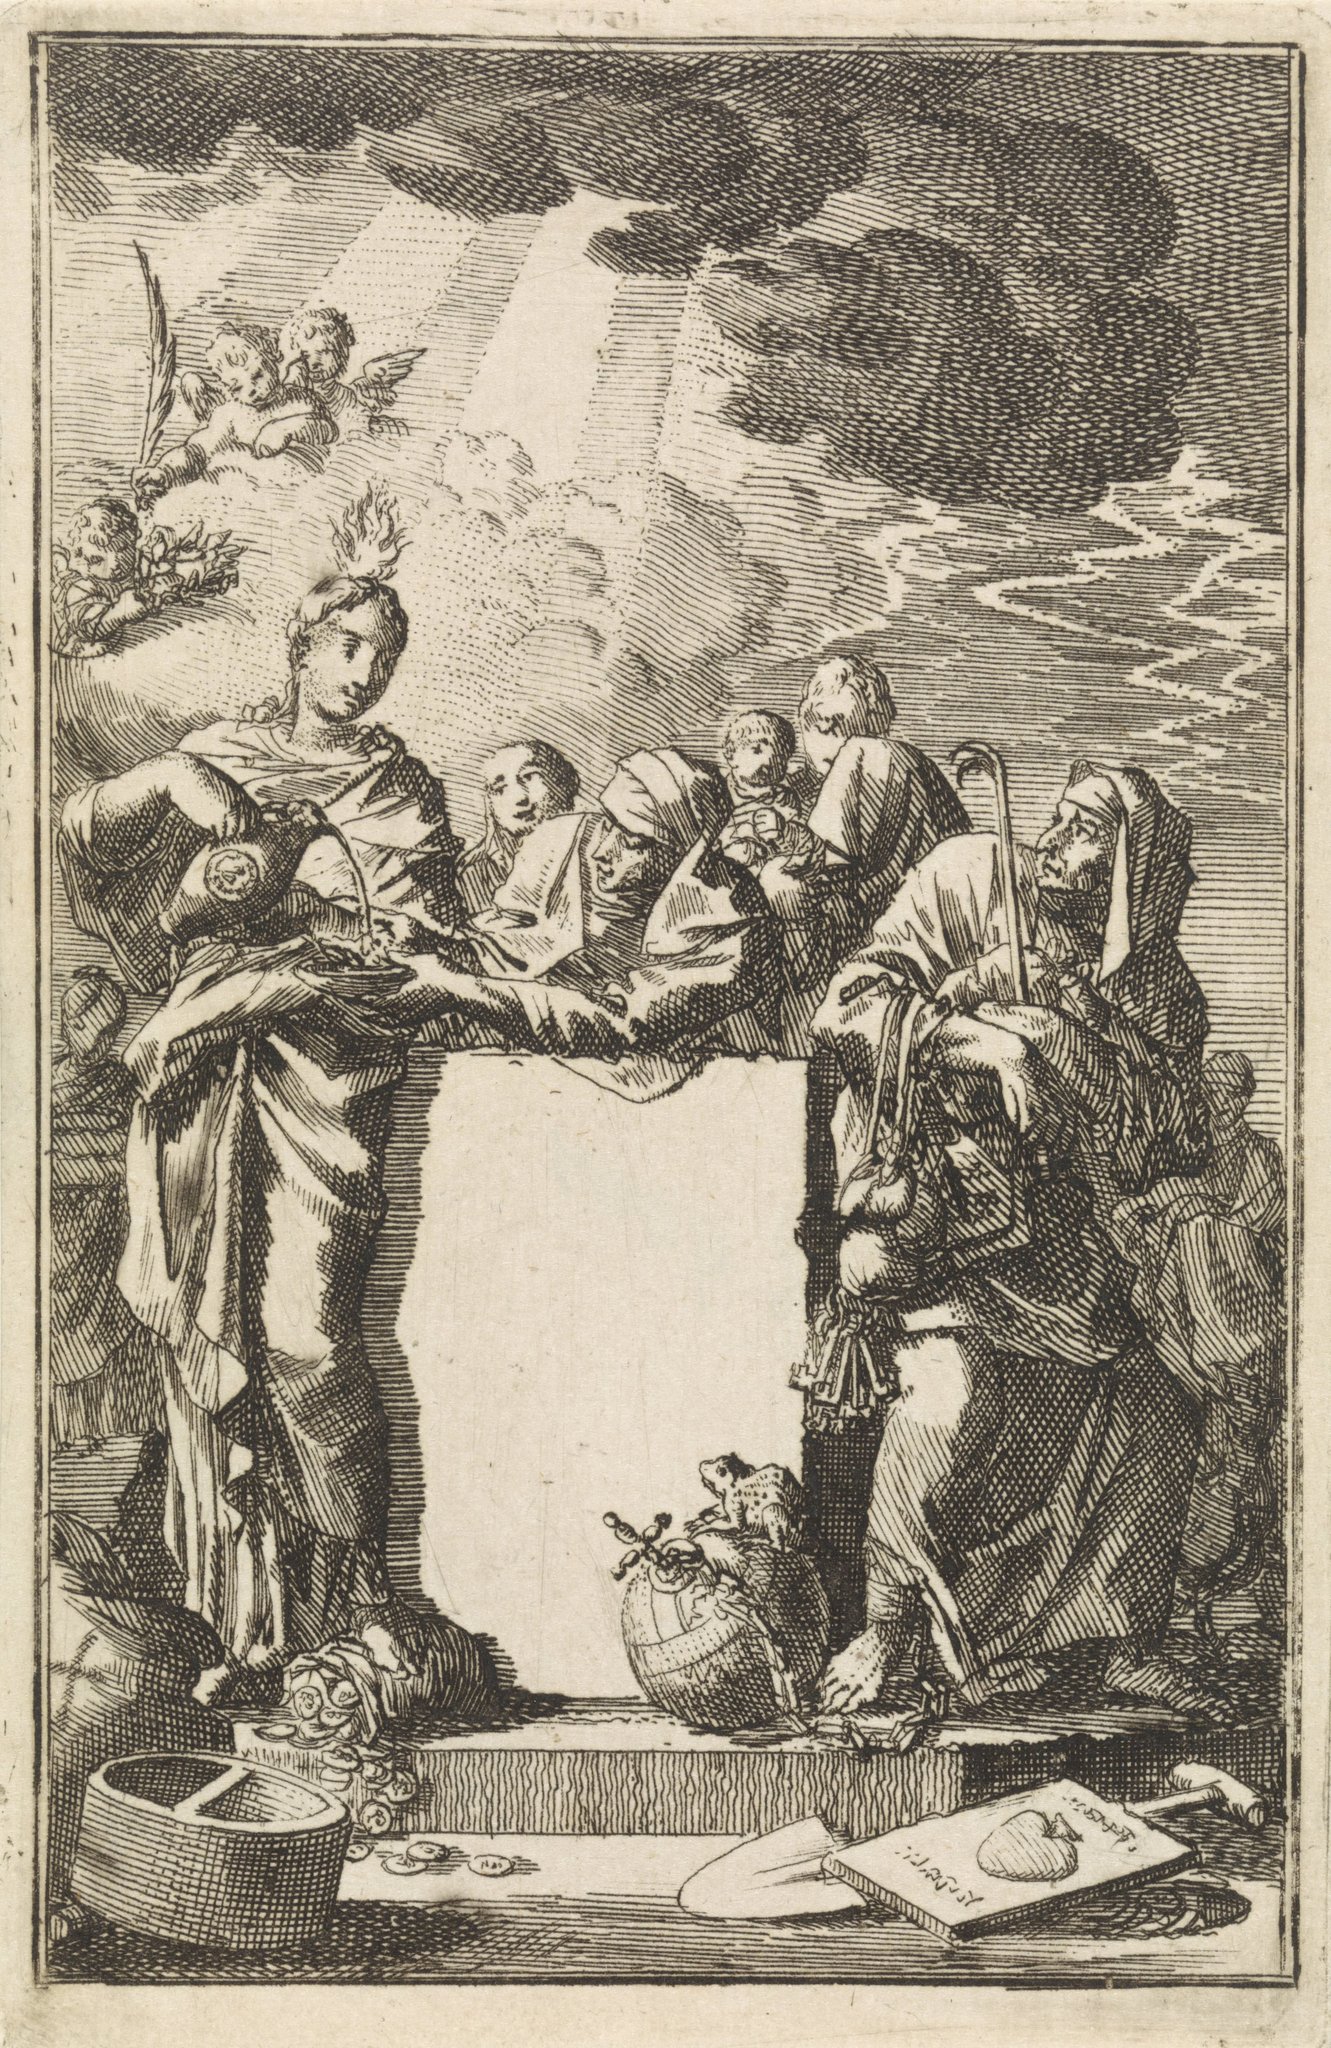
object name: print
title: Titelpagina van Adriaan Spinniker 'De Werken en Vergelding Der Barmhertigheid En Ombarmhertigheid' 1711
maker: jan luyken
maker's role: draughtsman, print maker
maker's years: 1649-1712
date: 1711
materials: paper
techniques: etching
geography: amsterdam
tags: charity, 'caritas'; 'carità' (ripa) ~ one of the three theological virtues - mm - virtues triumphant, greed, covetousness, cupidity; 'cupidità' (ripa)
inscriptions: collector's mark: Lugt 2228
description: Een grote steen wordt geflankeerd door een personificatie van Barmharigheid, met een vlam op het hoofd, en een personificatie van Gierigheid, geketend aan een wereldbol waarop een pad zit.